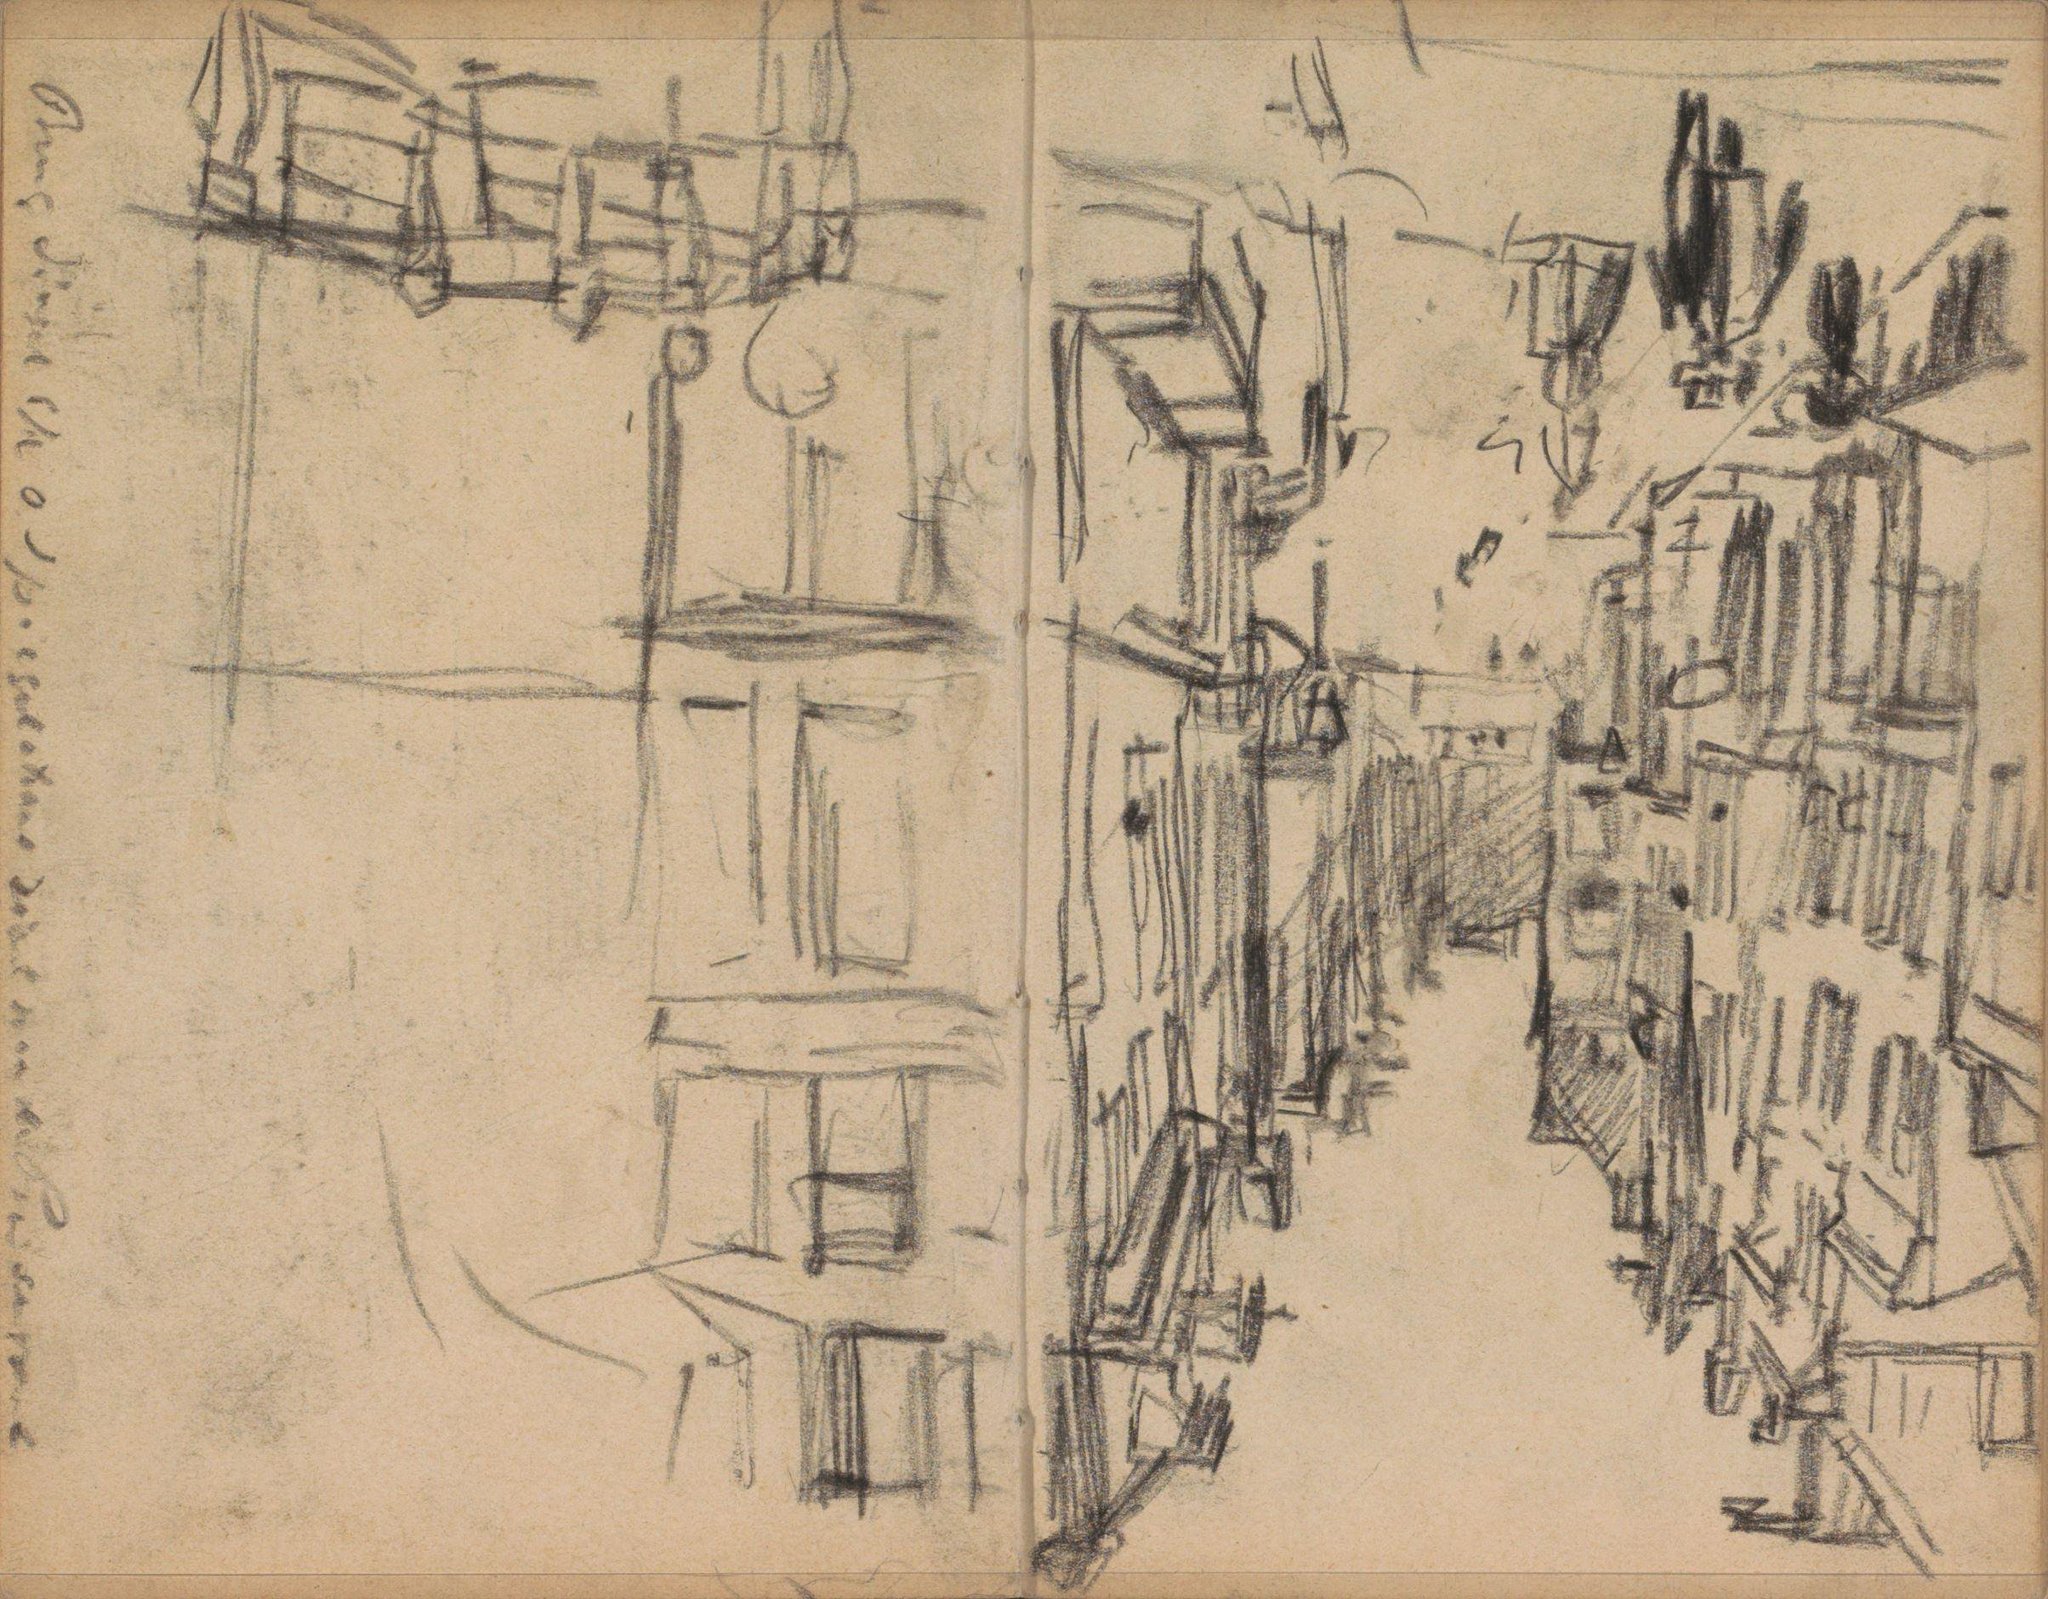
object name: sketchbook leaf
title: Oude Spiegelstraat te Amsterdam, gezien vanaf de brug over het Singel naar de Prinsengracht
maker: george hendrik breitner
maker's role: draughtsman, painter, print maker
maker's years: 1857-1923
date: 1886-1908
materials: chalk, paper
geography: amsterdam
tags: urban housing, bridge in city across river, canal, etc., street (+ city(-scape) with figures, staffage)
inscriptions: annotation: ‘Brug Singel b/d O. Spiegelstraat zicht naar de Prinsengracht’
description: Pagina 37 en pagina 38 uit een schetsboek met 46 bladen vervaardigd te Amsterdam, Haarlem en Antwerpen.